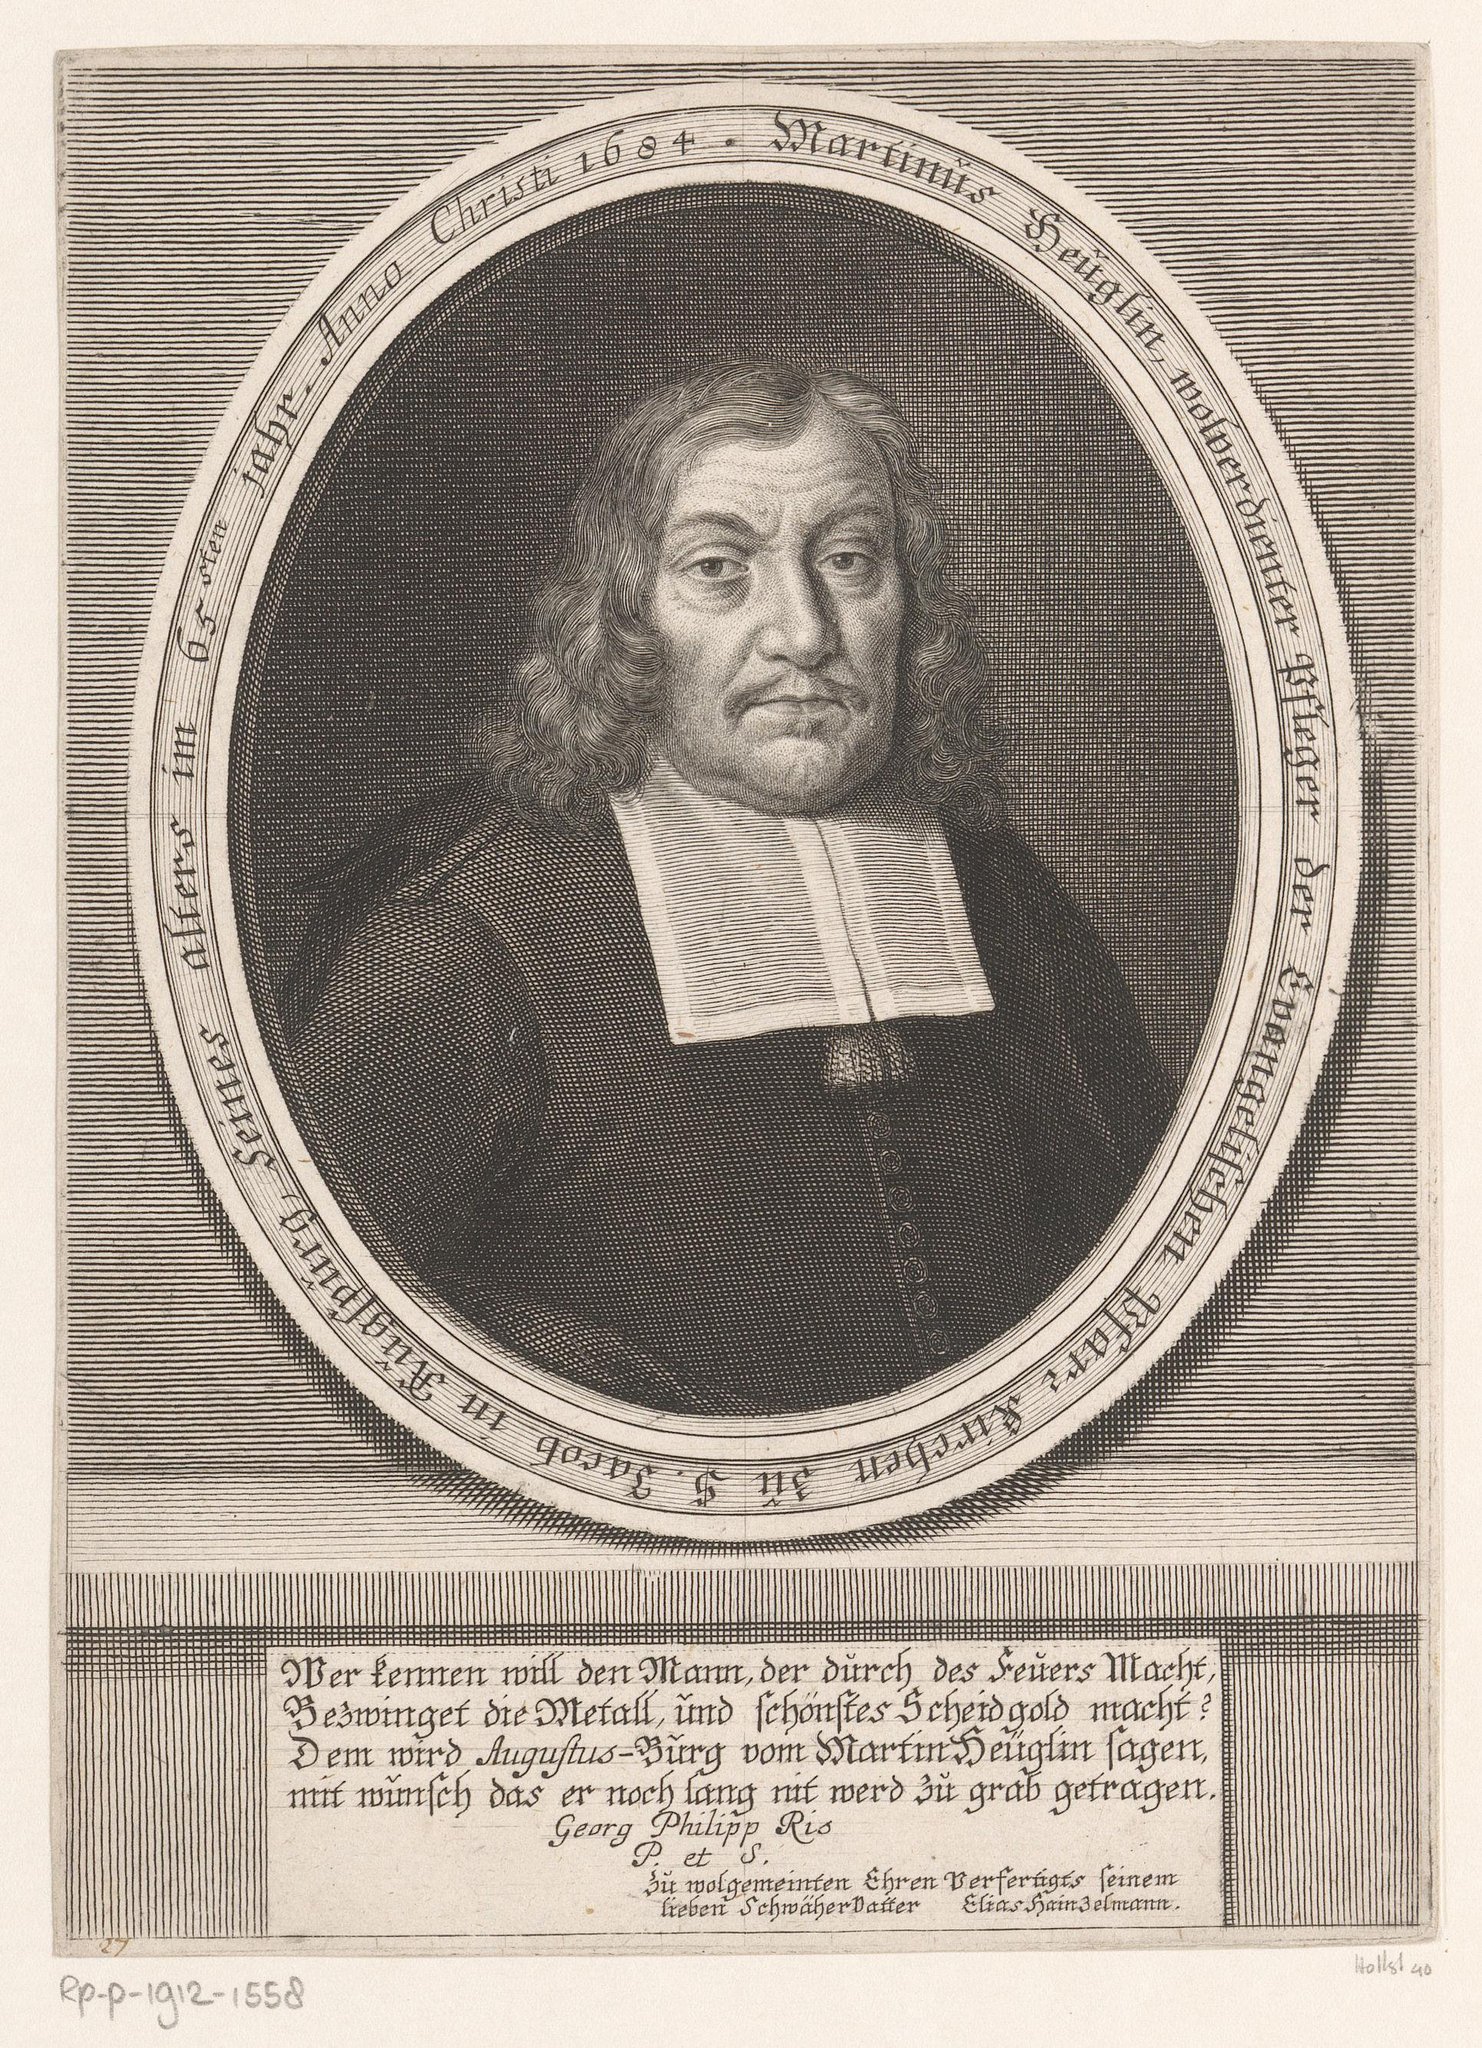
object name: print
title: Portret van Martin Heuglin op 65-jarige leeftijd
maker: elias hainzelmann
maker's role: artist, print maker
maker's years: 1640-1693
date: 1684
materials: paper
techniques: engraving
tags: augsburg, goldsmith, historical persons, jeweller, goldsmith, silversmith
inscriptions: collector's mark: Lugt 2228